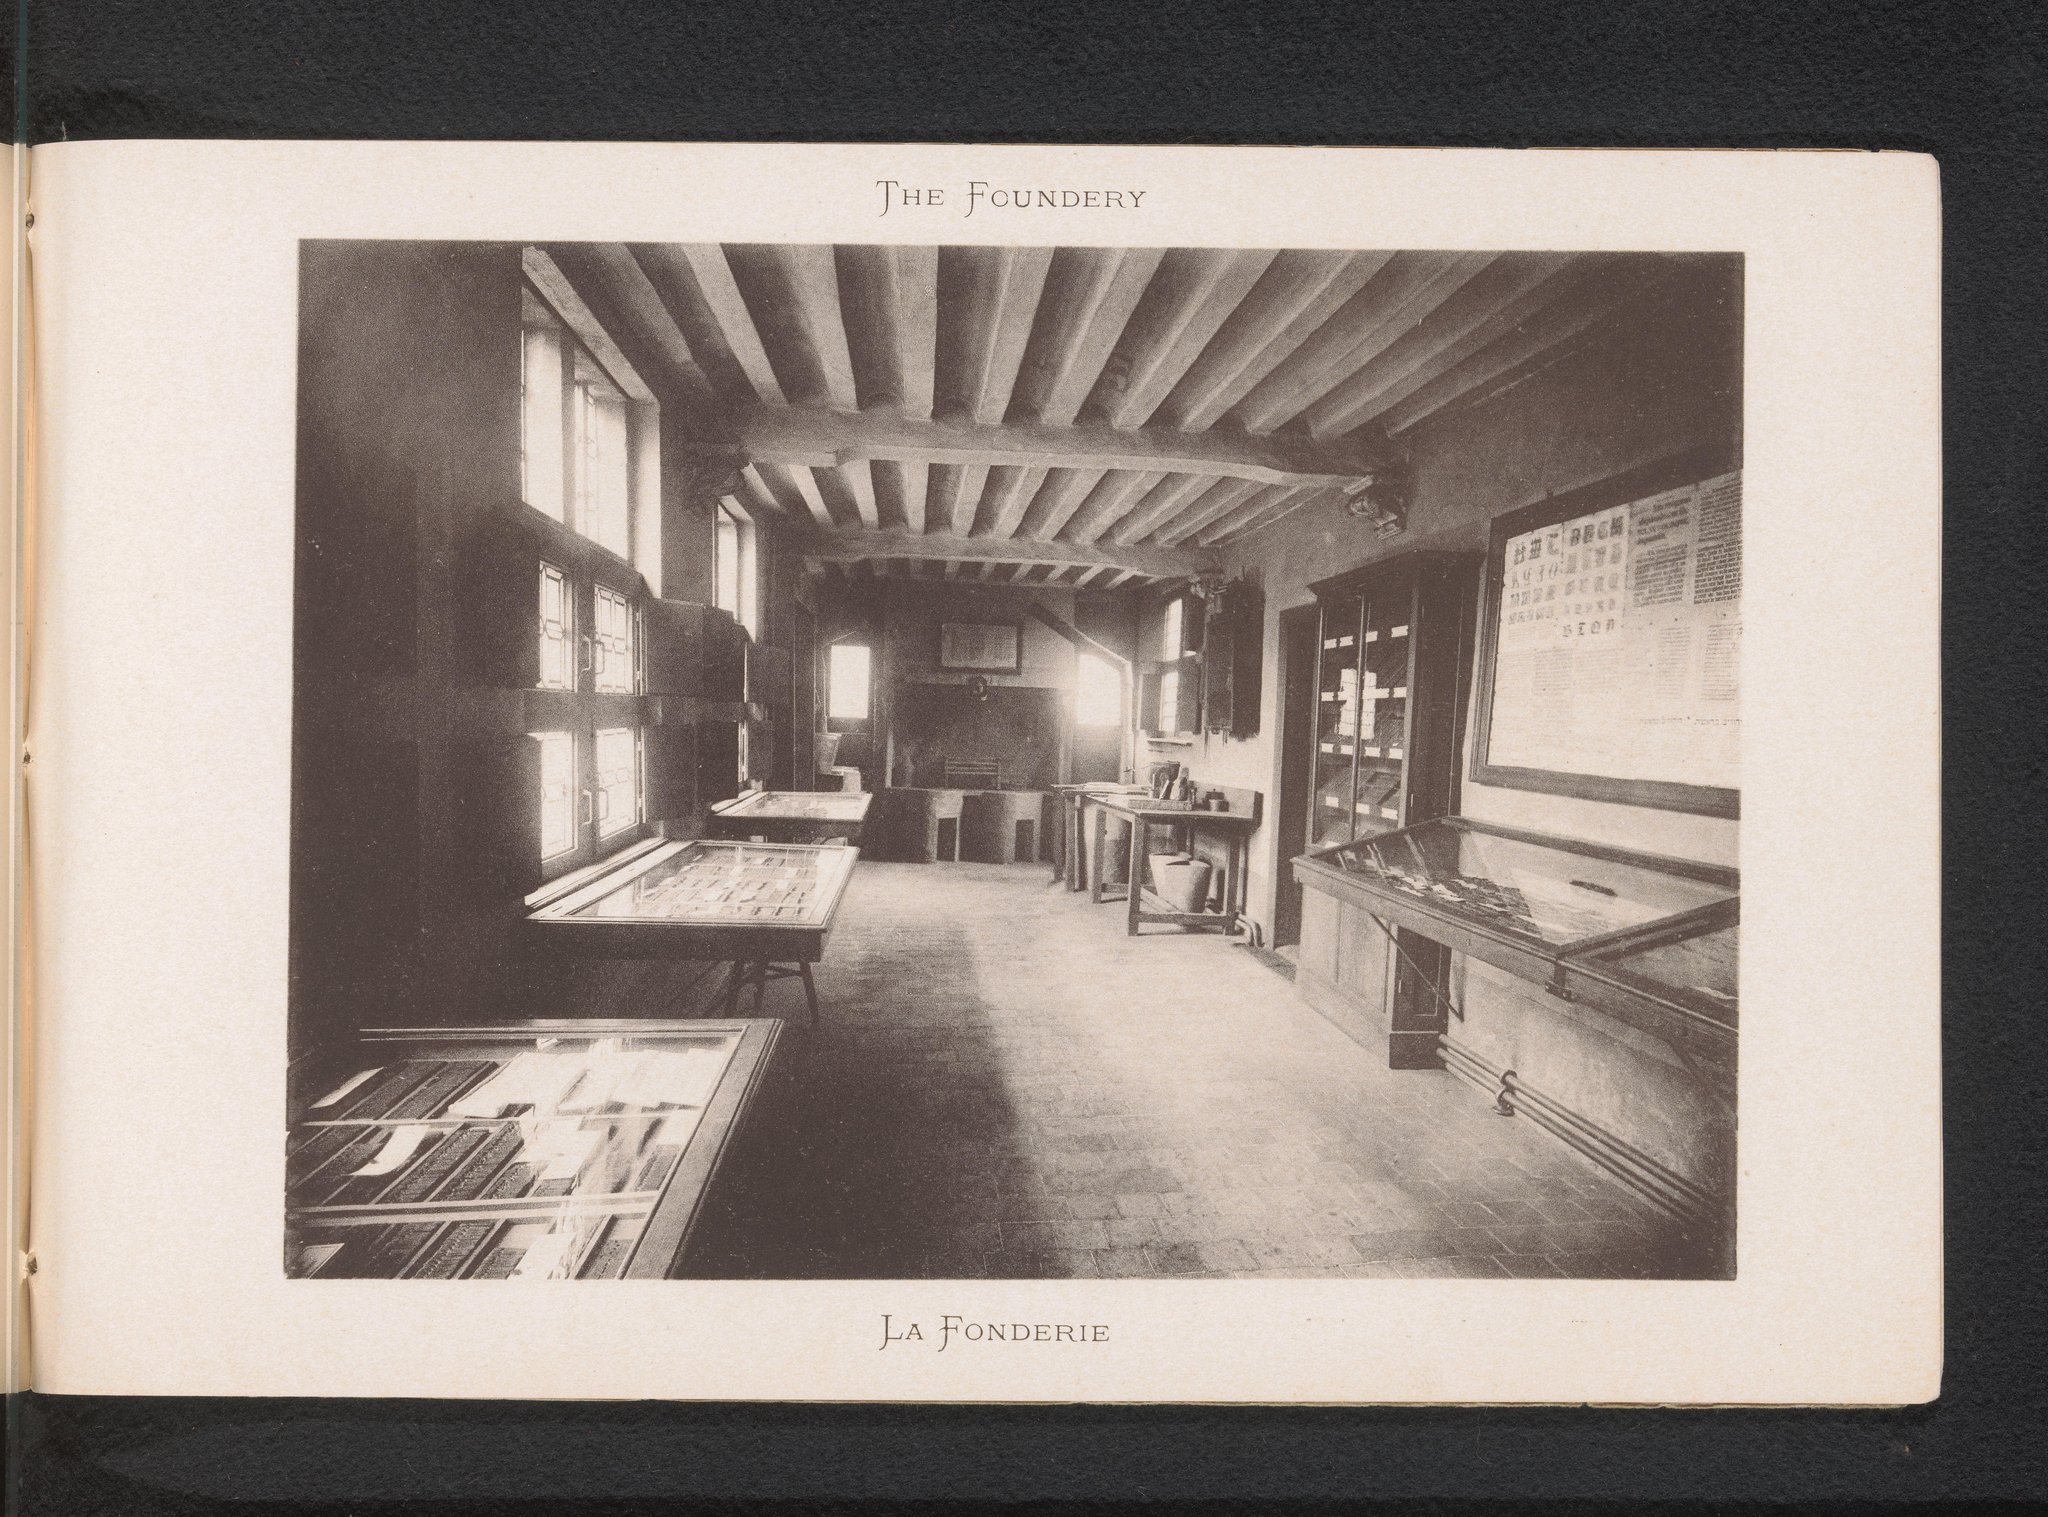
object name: page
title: De gieterij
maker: Anonymous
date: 1892-1897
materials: paper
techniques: photograph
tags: workshop-interior